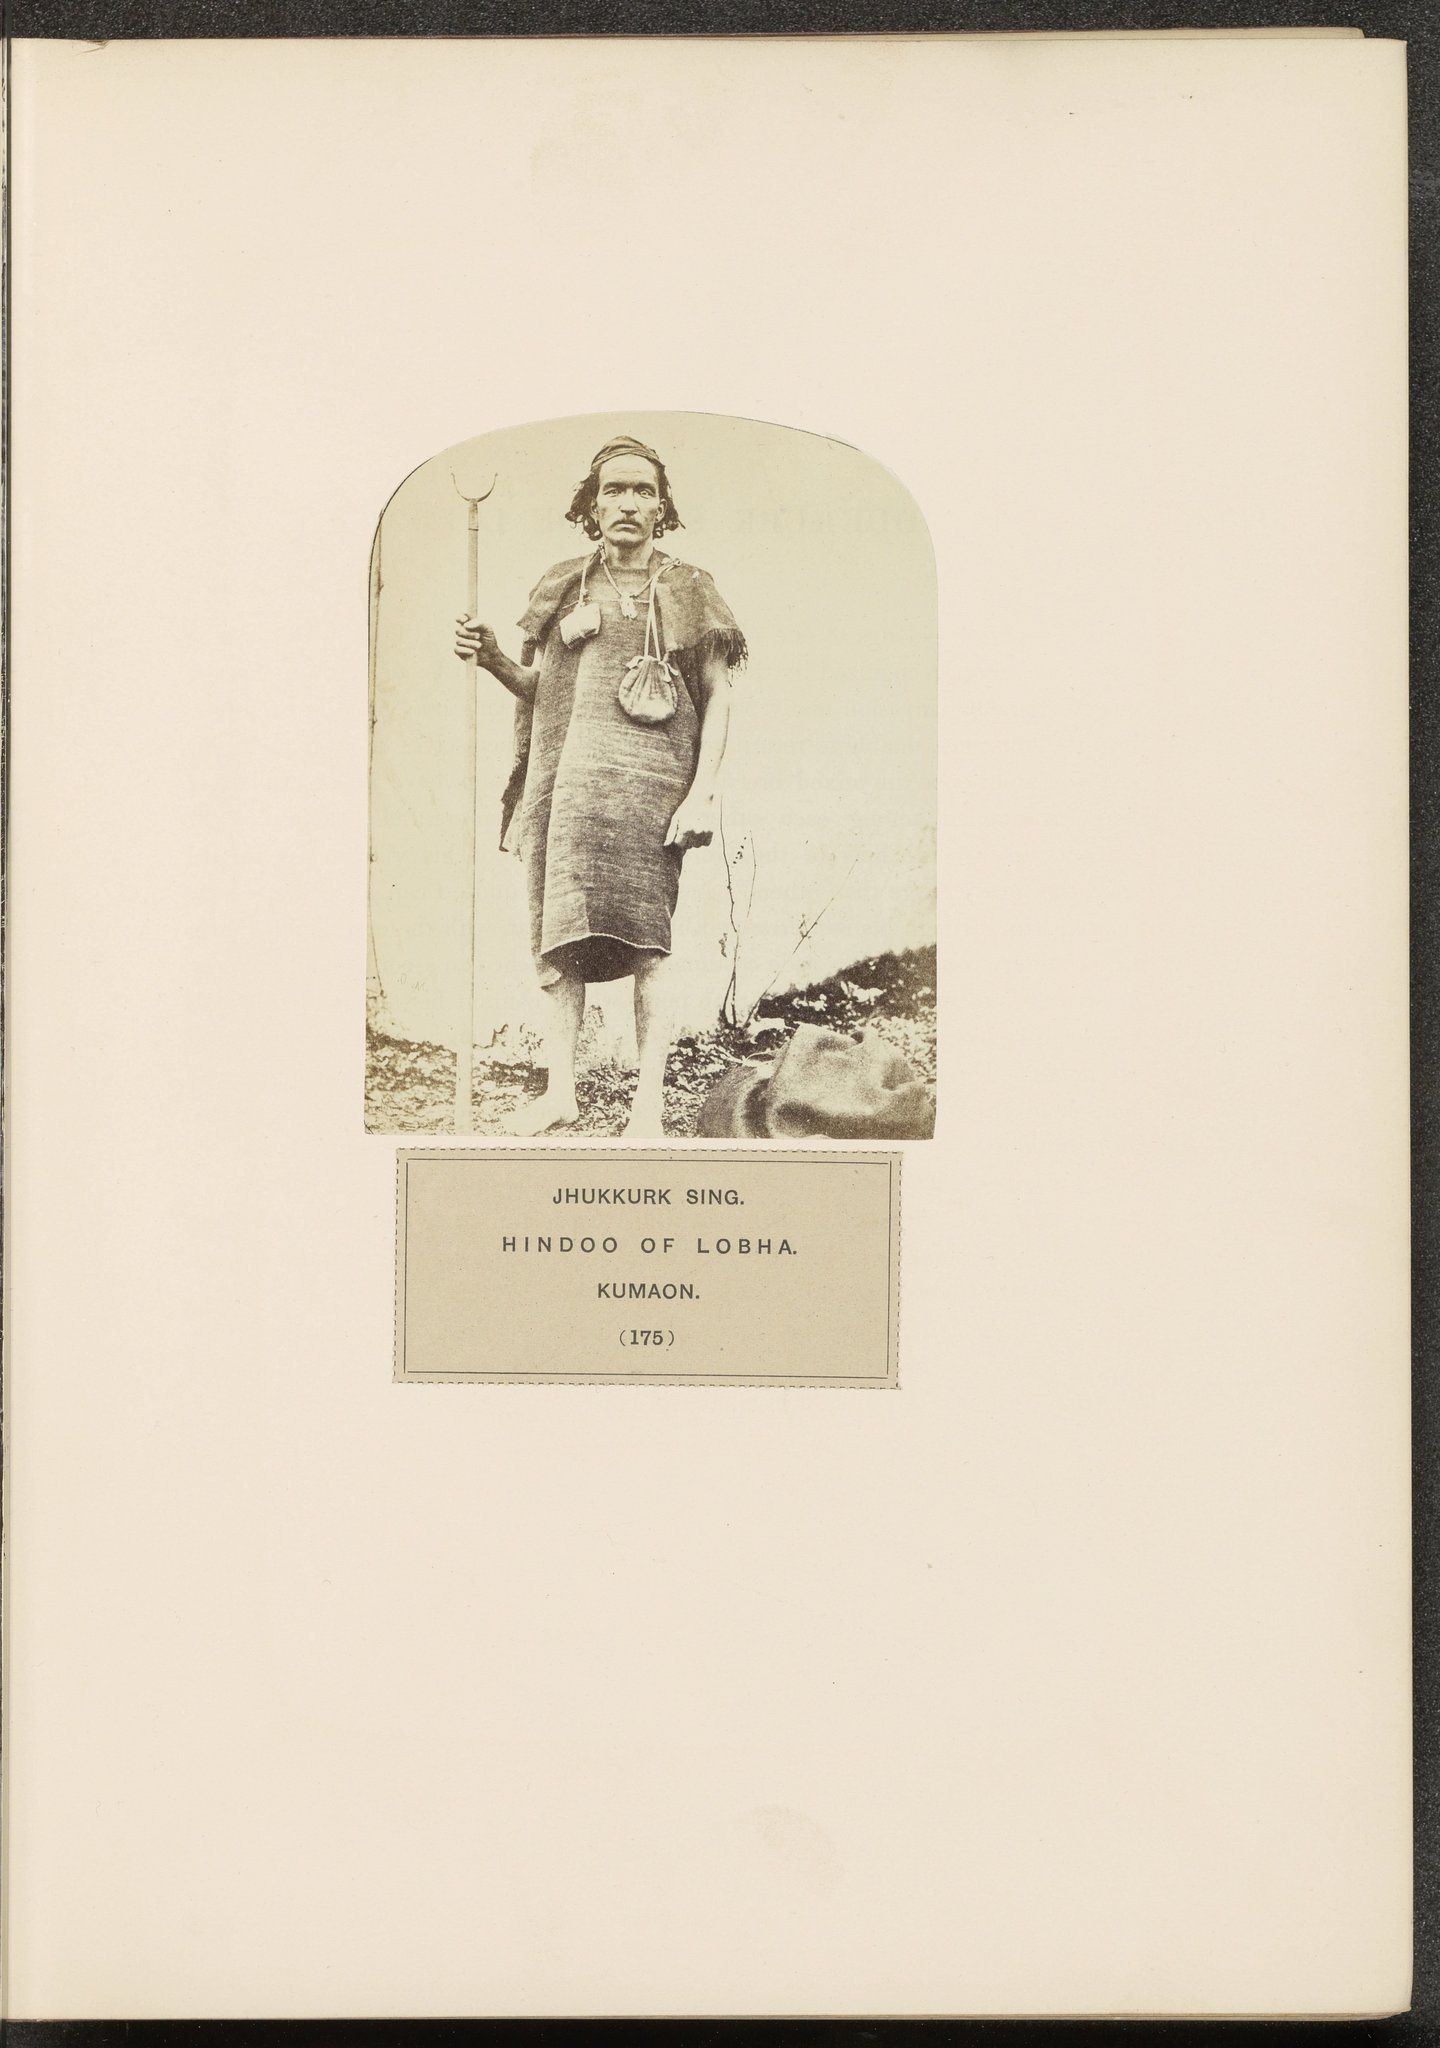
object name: photograph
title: Portrait of Jhukkurk Sing, a man with a walking stick from Kumaon, Uttarakhand, India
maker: Anonymous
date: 1859-1869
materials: photographic support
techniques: albumen print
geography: kumaon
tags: human races; peoples; nationalities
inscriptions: number: ‘(175)’, inscription: ‘JHUKKURK SING./ HINDOO OF LOBHA./ KUMAON.’